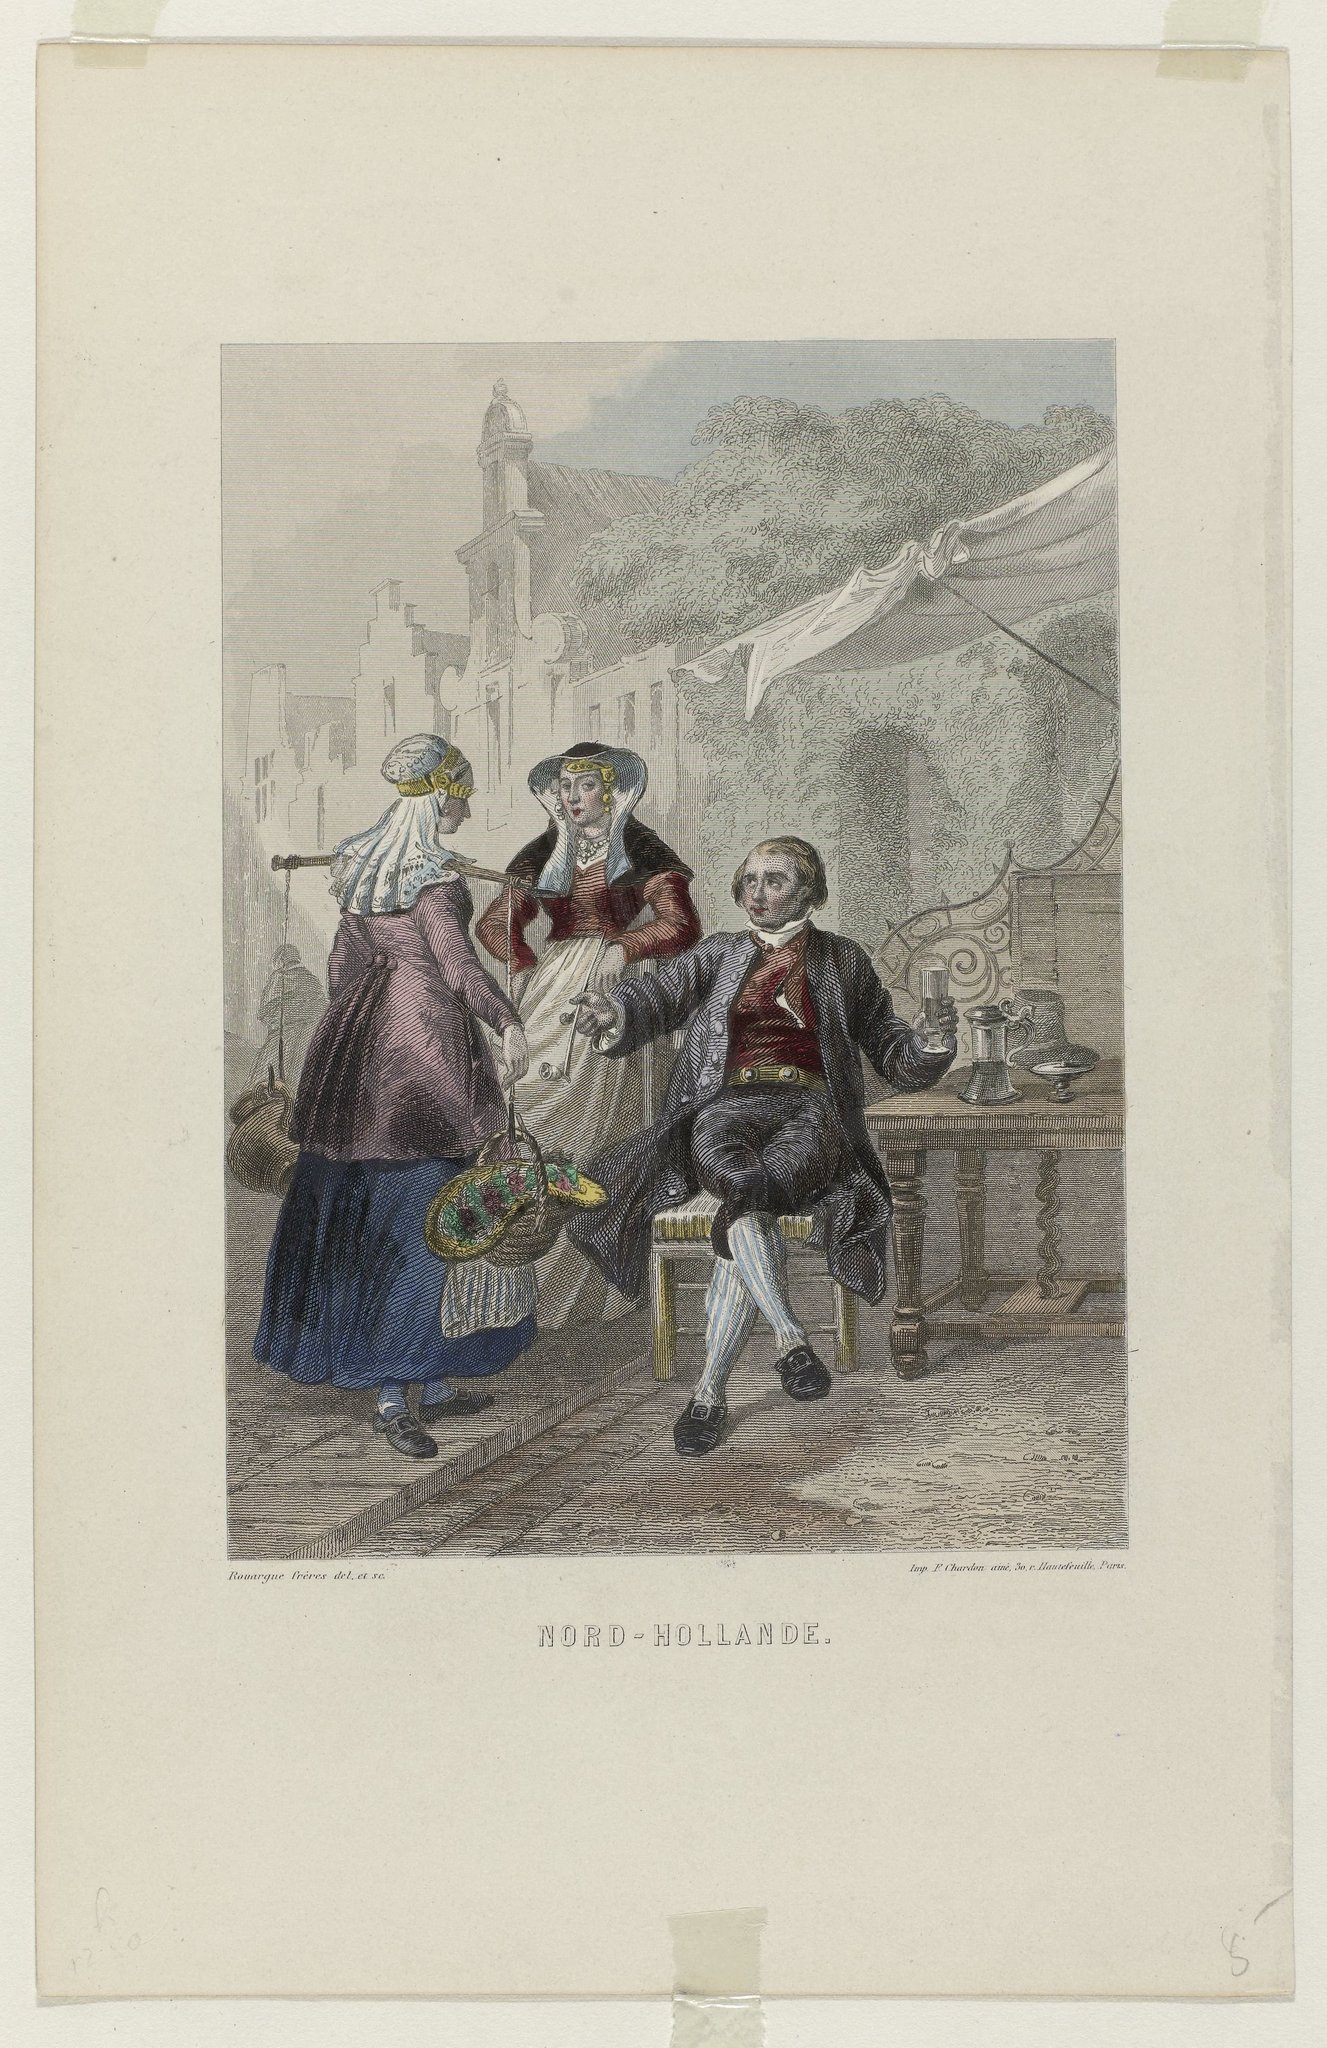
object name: print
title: Nord-Hollande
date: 1800-1899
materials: paper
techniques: etching, hand coloring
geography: paris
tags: pipe ~ tobacco, clothes, costume (+ women's clothes), clothes, costume (+ men's clothes), drinking-vessels, folk costume, regional costume, street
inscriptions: caption: ‘NORD-HOLLANDE.’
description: Twee vrouwen en een man in klederdracht uit Noord-Holland.